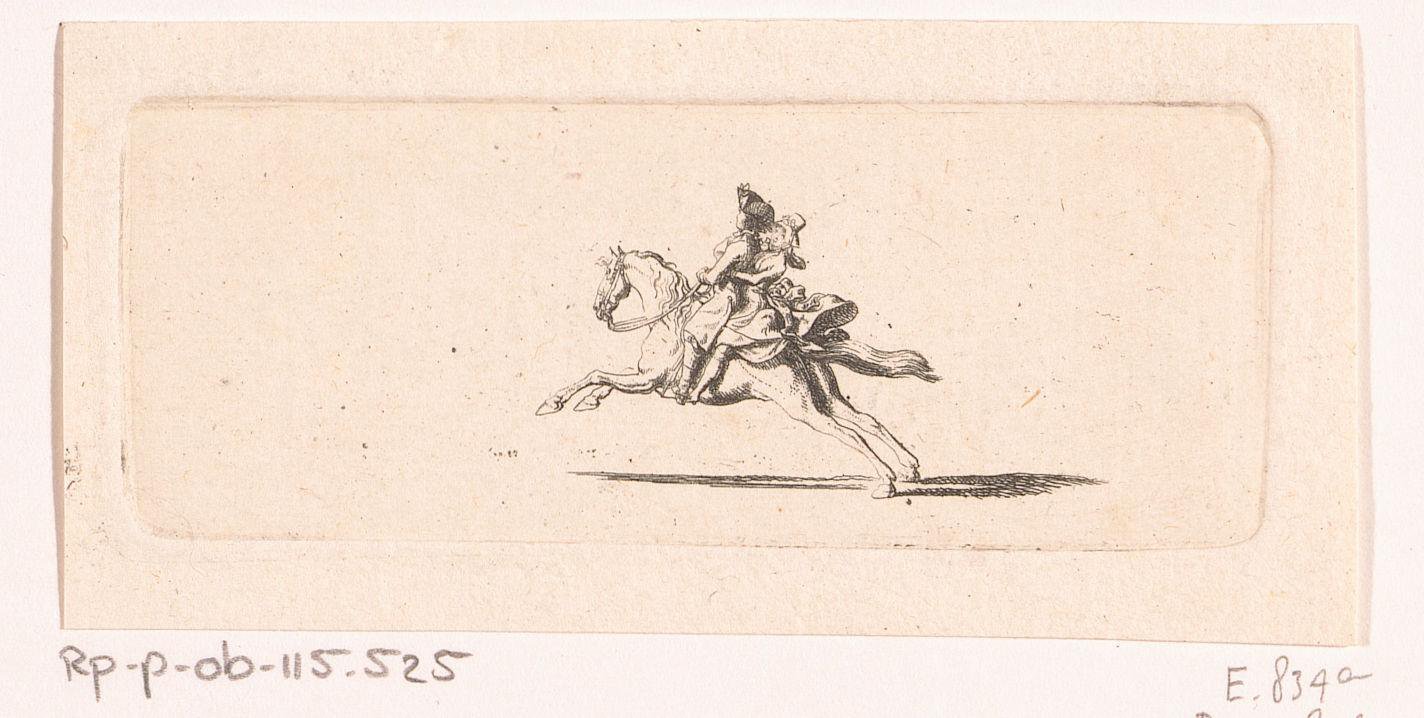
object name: print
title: Vluchtende ruiter met dame achterop zijn paard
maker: daniel nikolaus chodowiecki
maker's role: draughtsman, print maker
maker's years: 1726-1801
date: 1796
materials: paper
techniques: etching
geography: berlin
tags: riding a horse, ass, or mule; rider, horseman, political refugee, 'émigré'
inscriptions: collector's mark: Lugt 2228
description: Deze prent was, met nog vijf andere schetsmatige marge voorstellingen, onderdeel van de plaat waarop de prent 'Vluchtende mensen komen aan bij Hanau' was geëtst. Later is deze plaat versneden.